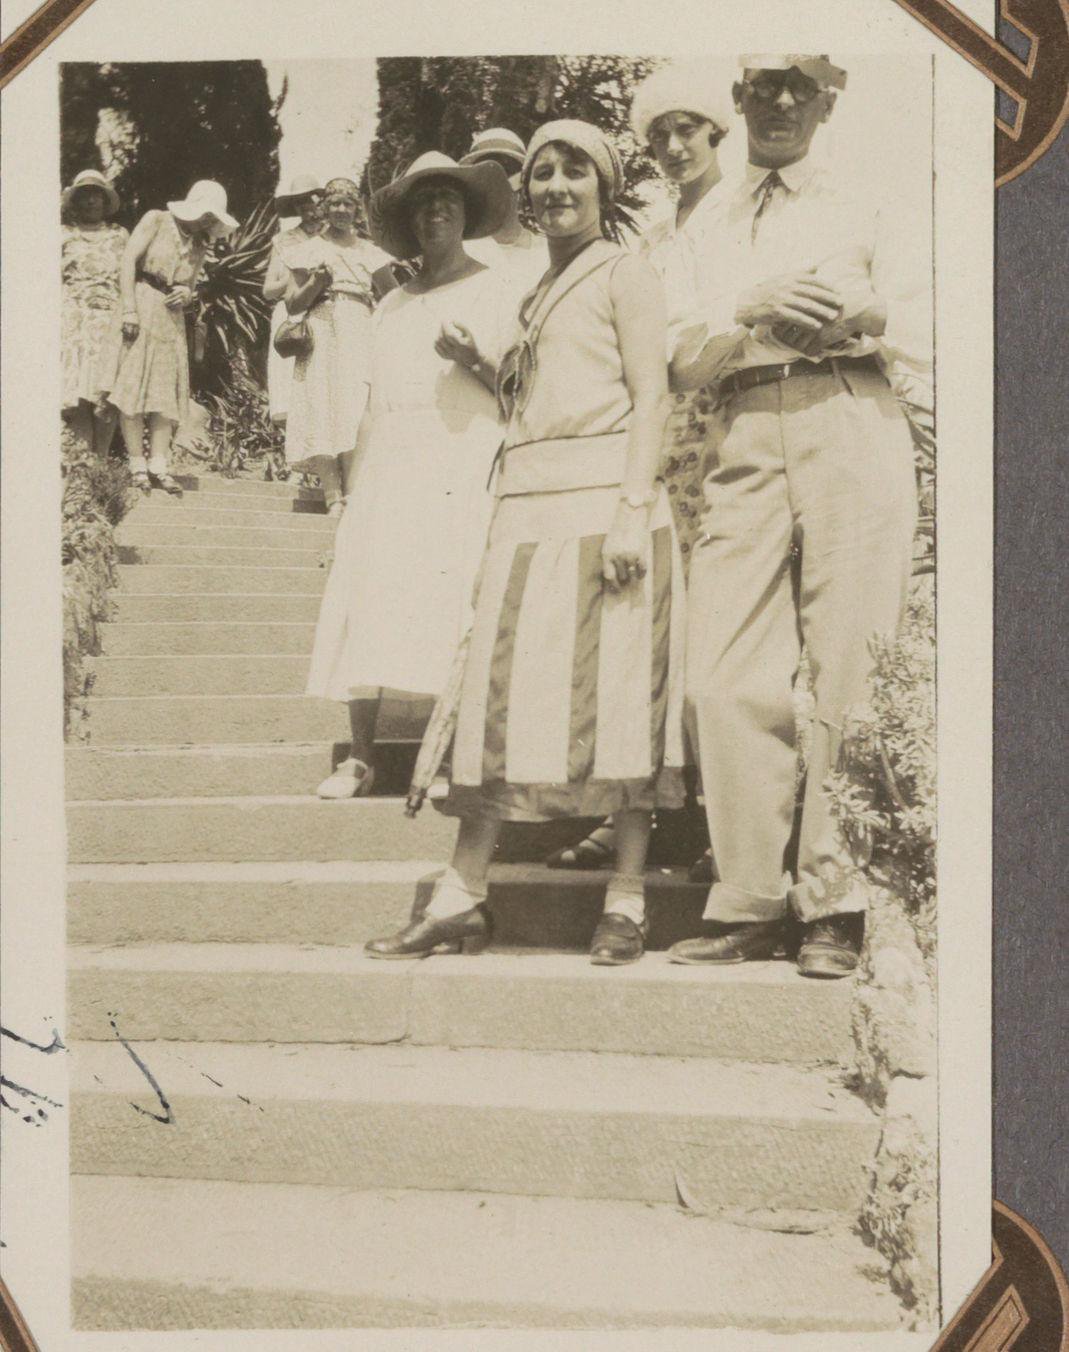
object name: photograph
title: Gezelschap op een stenen trap, vermoedelijk in Zuid-Frankrijk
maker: Anonymous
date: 1931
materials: photographic support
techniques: gelatin silver print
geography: southern france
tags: adult woman, sloping street; street with steps or stairs, adult man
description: Onderdeel van Fotoalbum met opnames van vakanties in Zuid-Frankrijk.